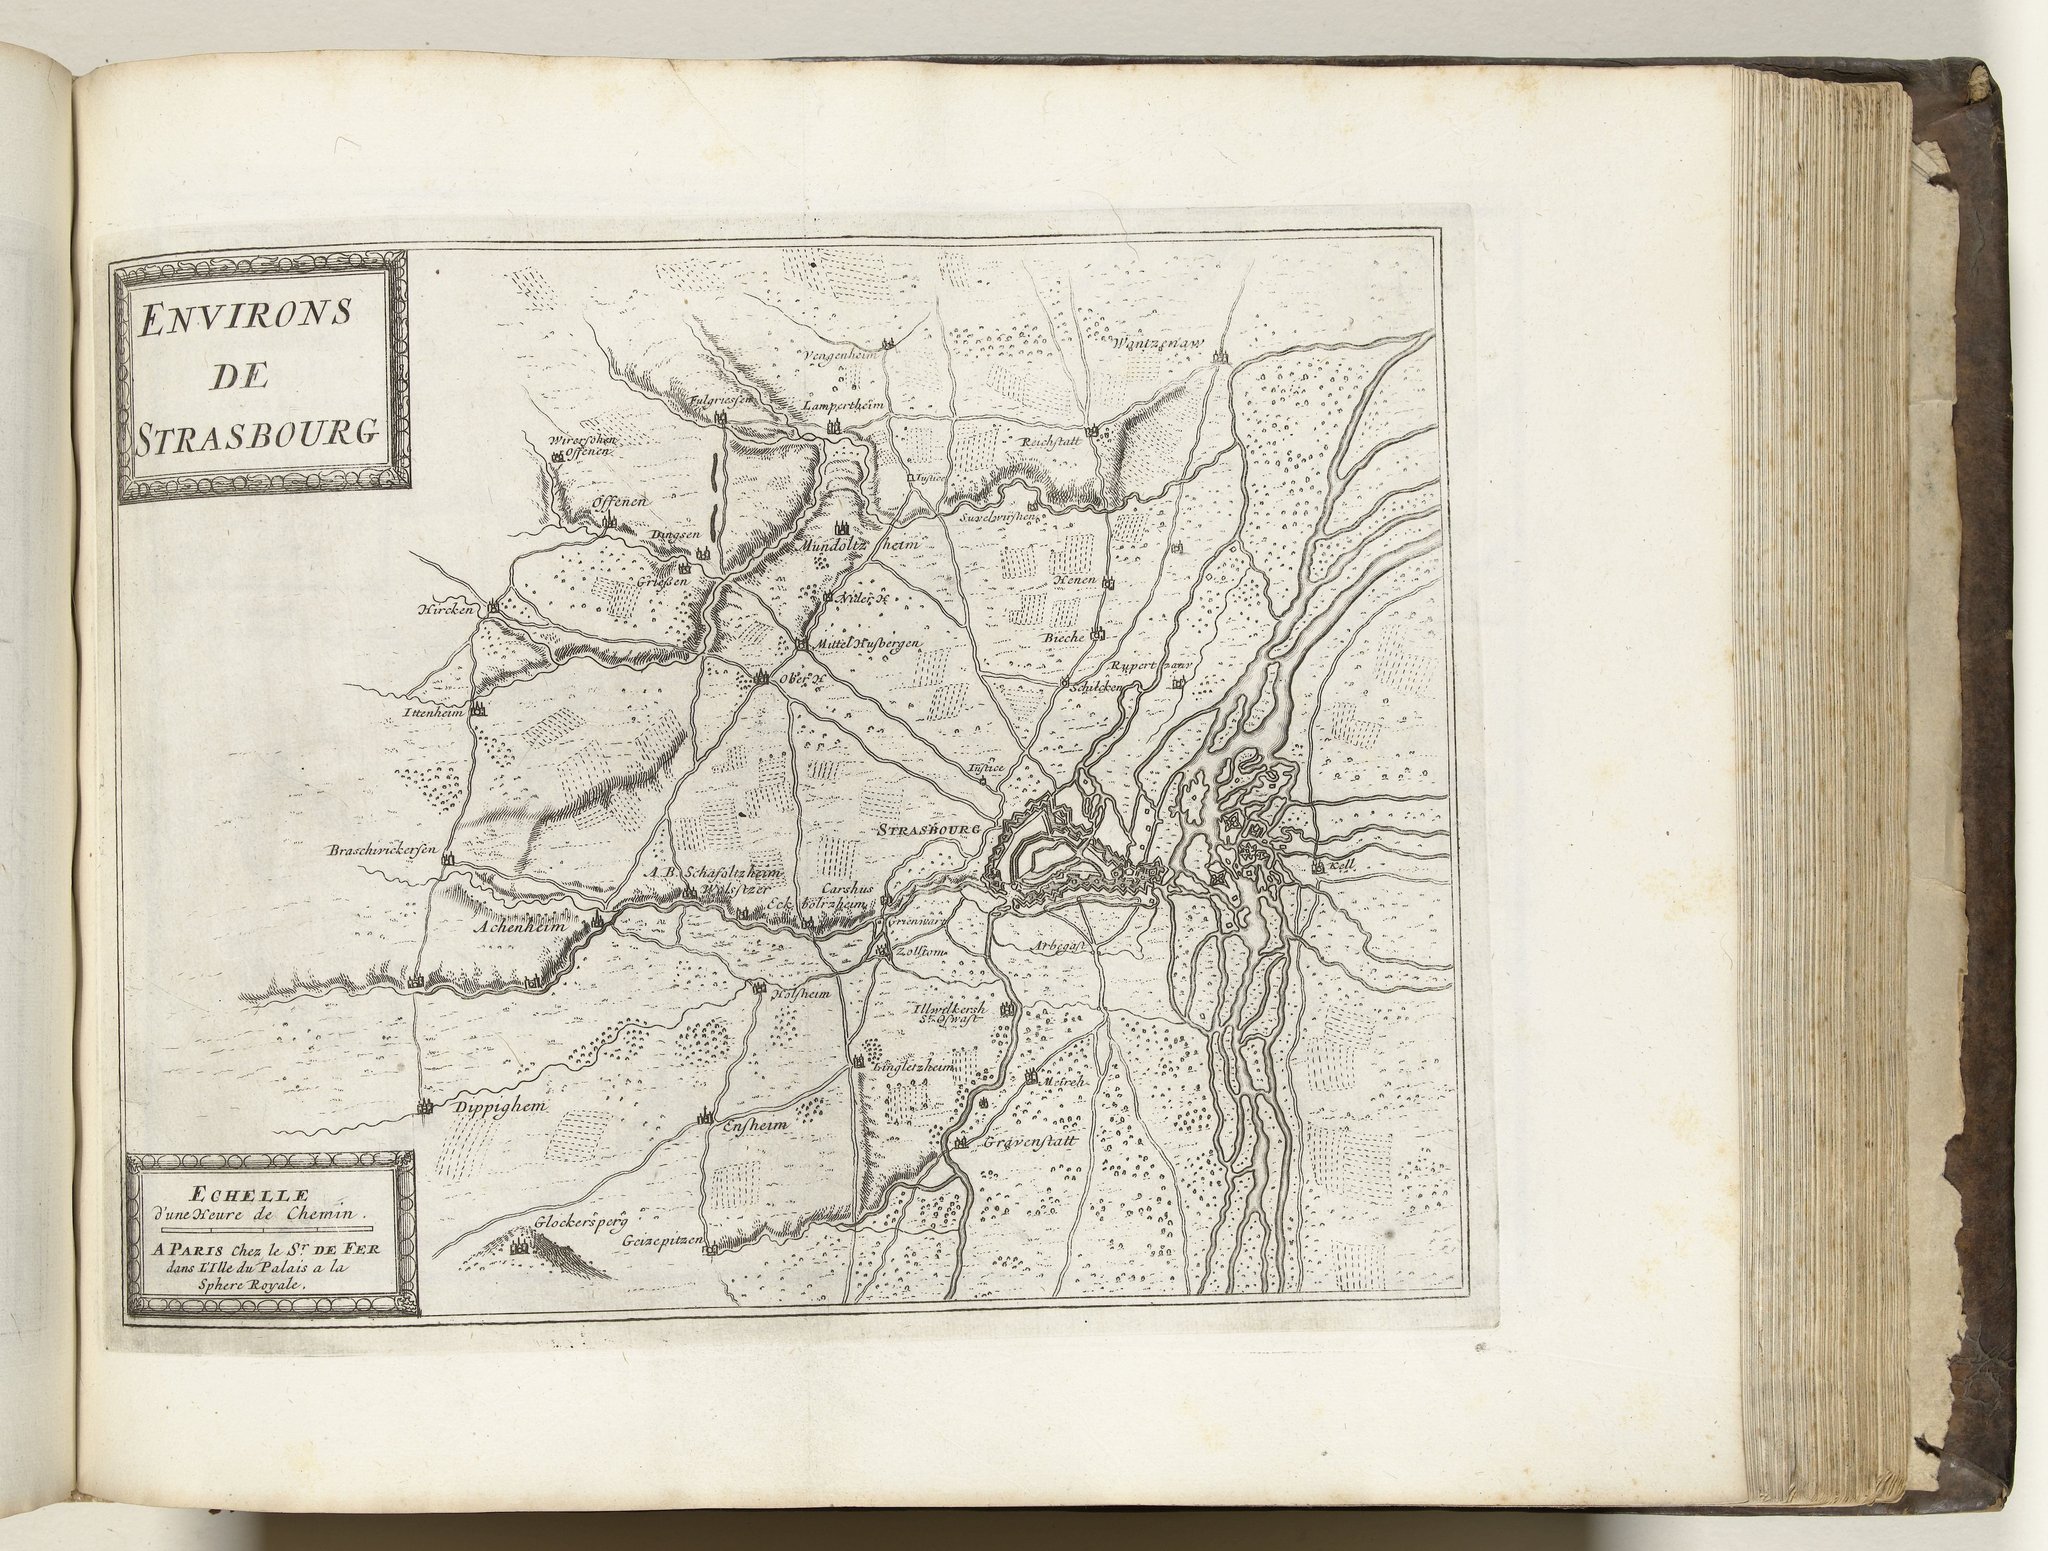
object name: print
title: Les forces de l'Europe, ou description des principales villes, avec leurs fortifications : dessignées par les meilleurs ingenieurs, particulierement celles (...) de la France, dont les plans ont esté levez par M. de Vauban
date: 1693-1696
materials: paper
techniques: etching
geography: france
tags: maps of separate countries or regions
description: Kaart van de omgeving van de Franse stad Straatsburg. Onderdeel van het zevende deel (1696) van het prentwerk waarin gebundeld zijn de acht delen van Les forces de l'Europe uitgegeven tussen 1693-1697. Het prentwerk bestaat uit 175 platen met plannen (afkomstig van Sébastien Le Prestre, Seigneur de Vauban) van vermaarde sterke steden en vestingen in de Negenjarige Oorlog. Titel en opschriften in het Frans.